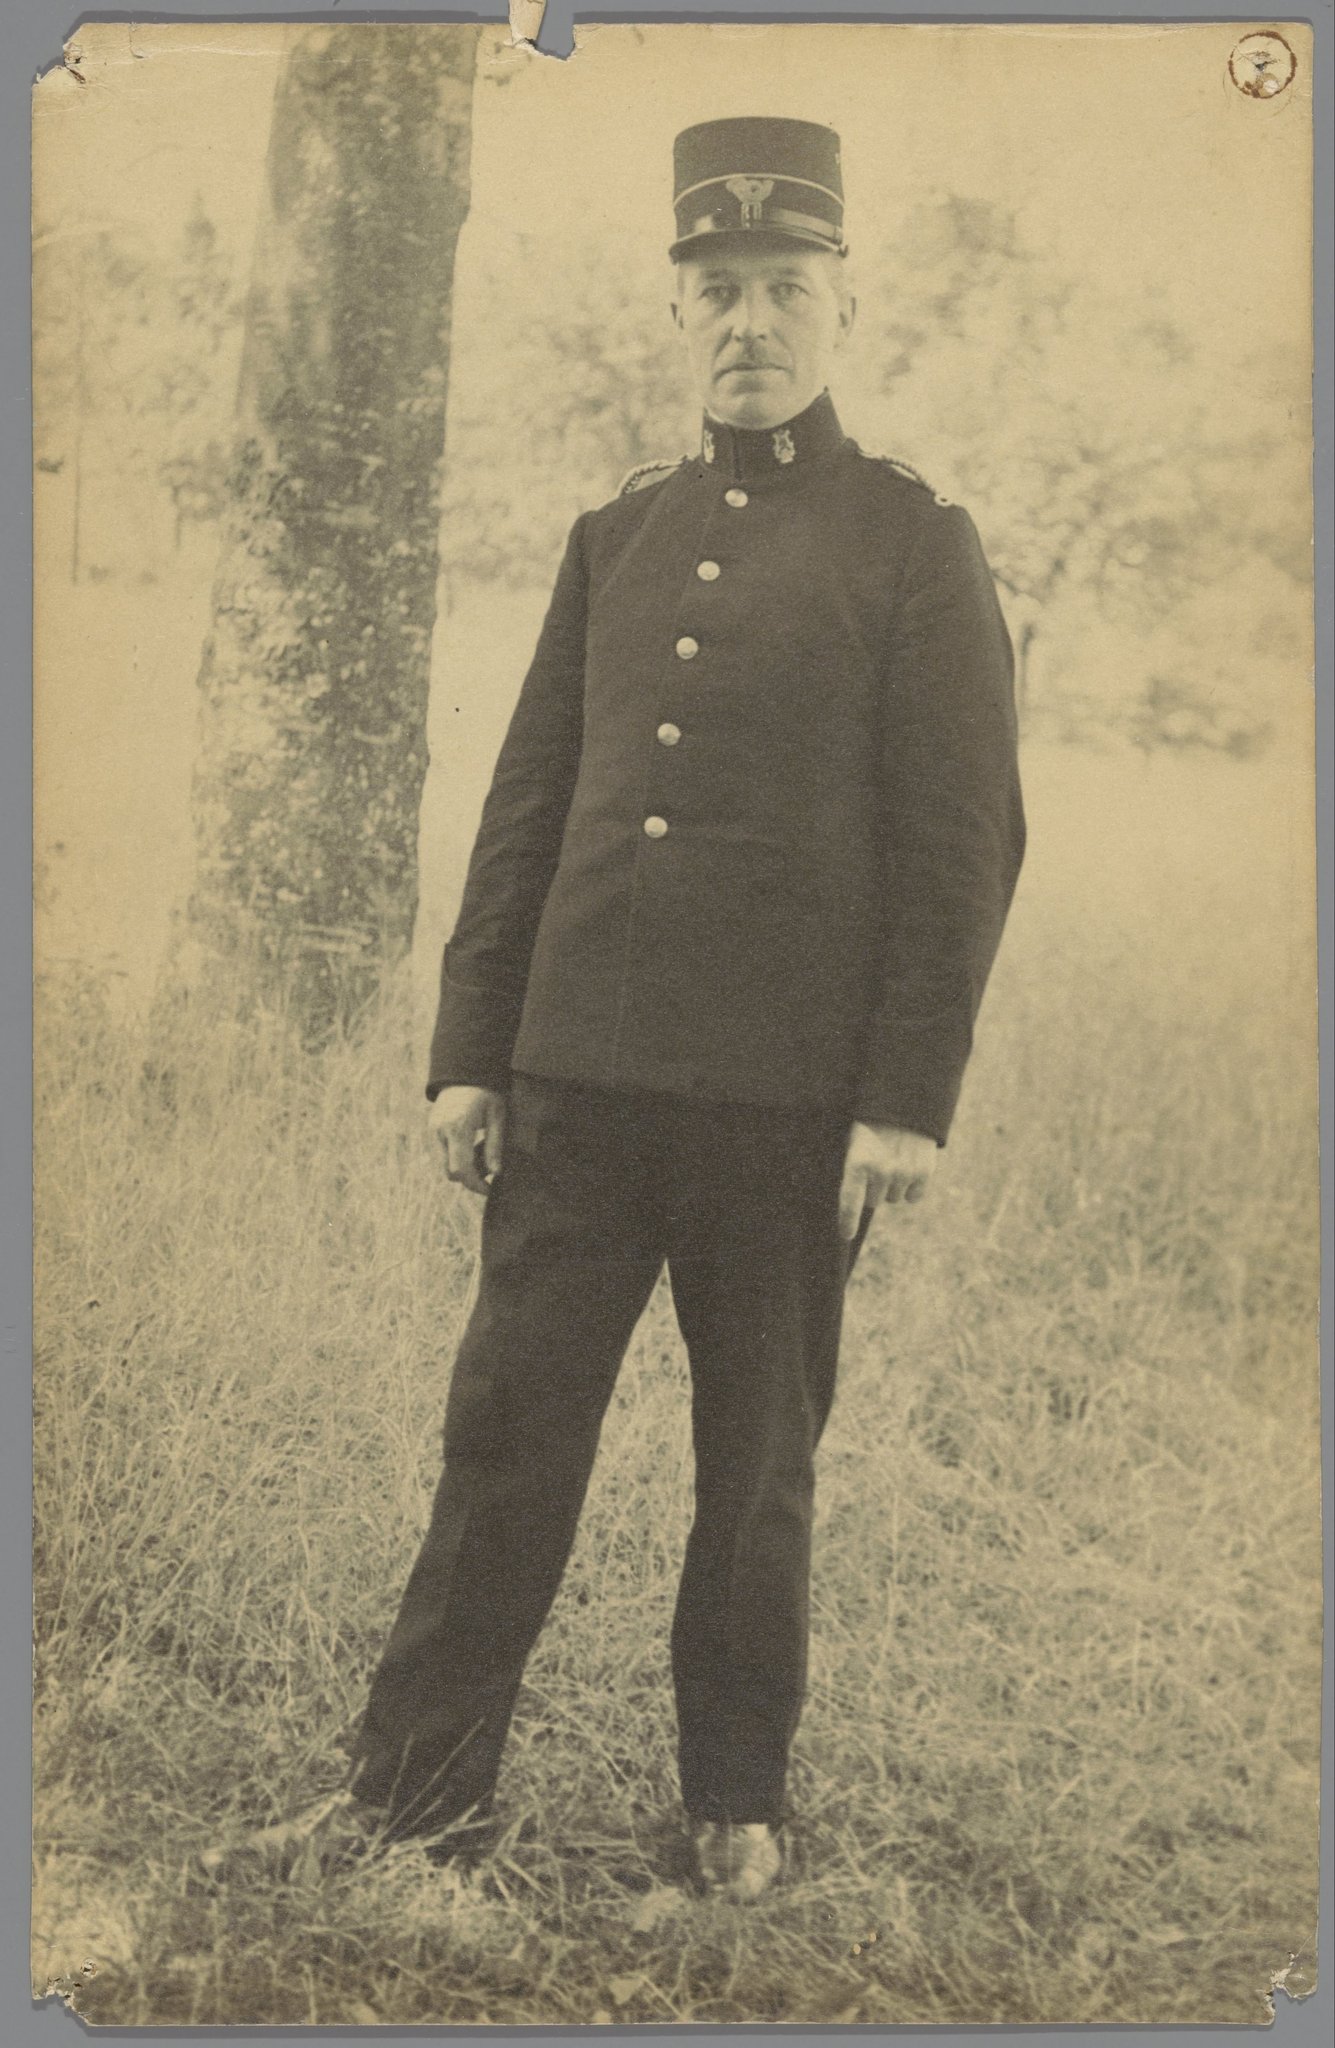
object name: photograph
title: Dirigent Dirk Speets van de Amsterdamsche Postharmonie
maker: Anonymous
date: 1919-1950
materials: photographic support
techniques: gelatin silver print